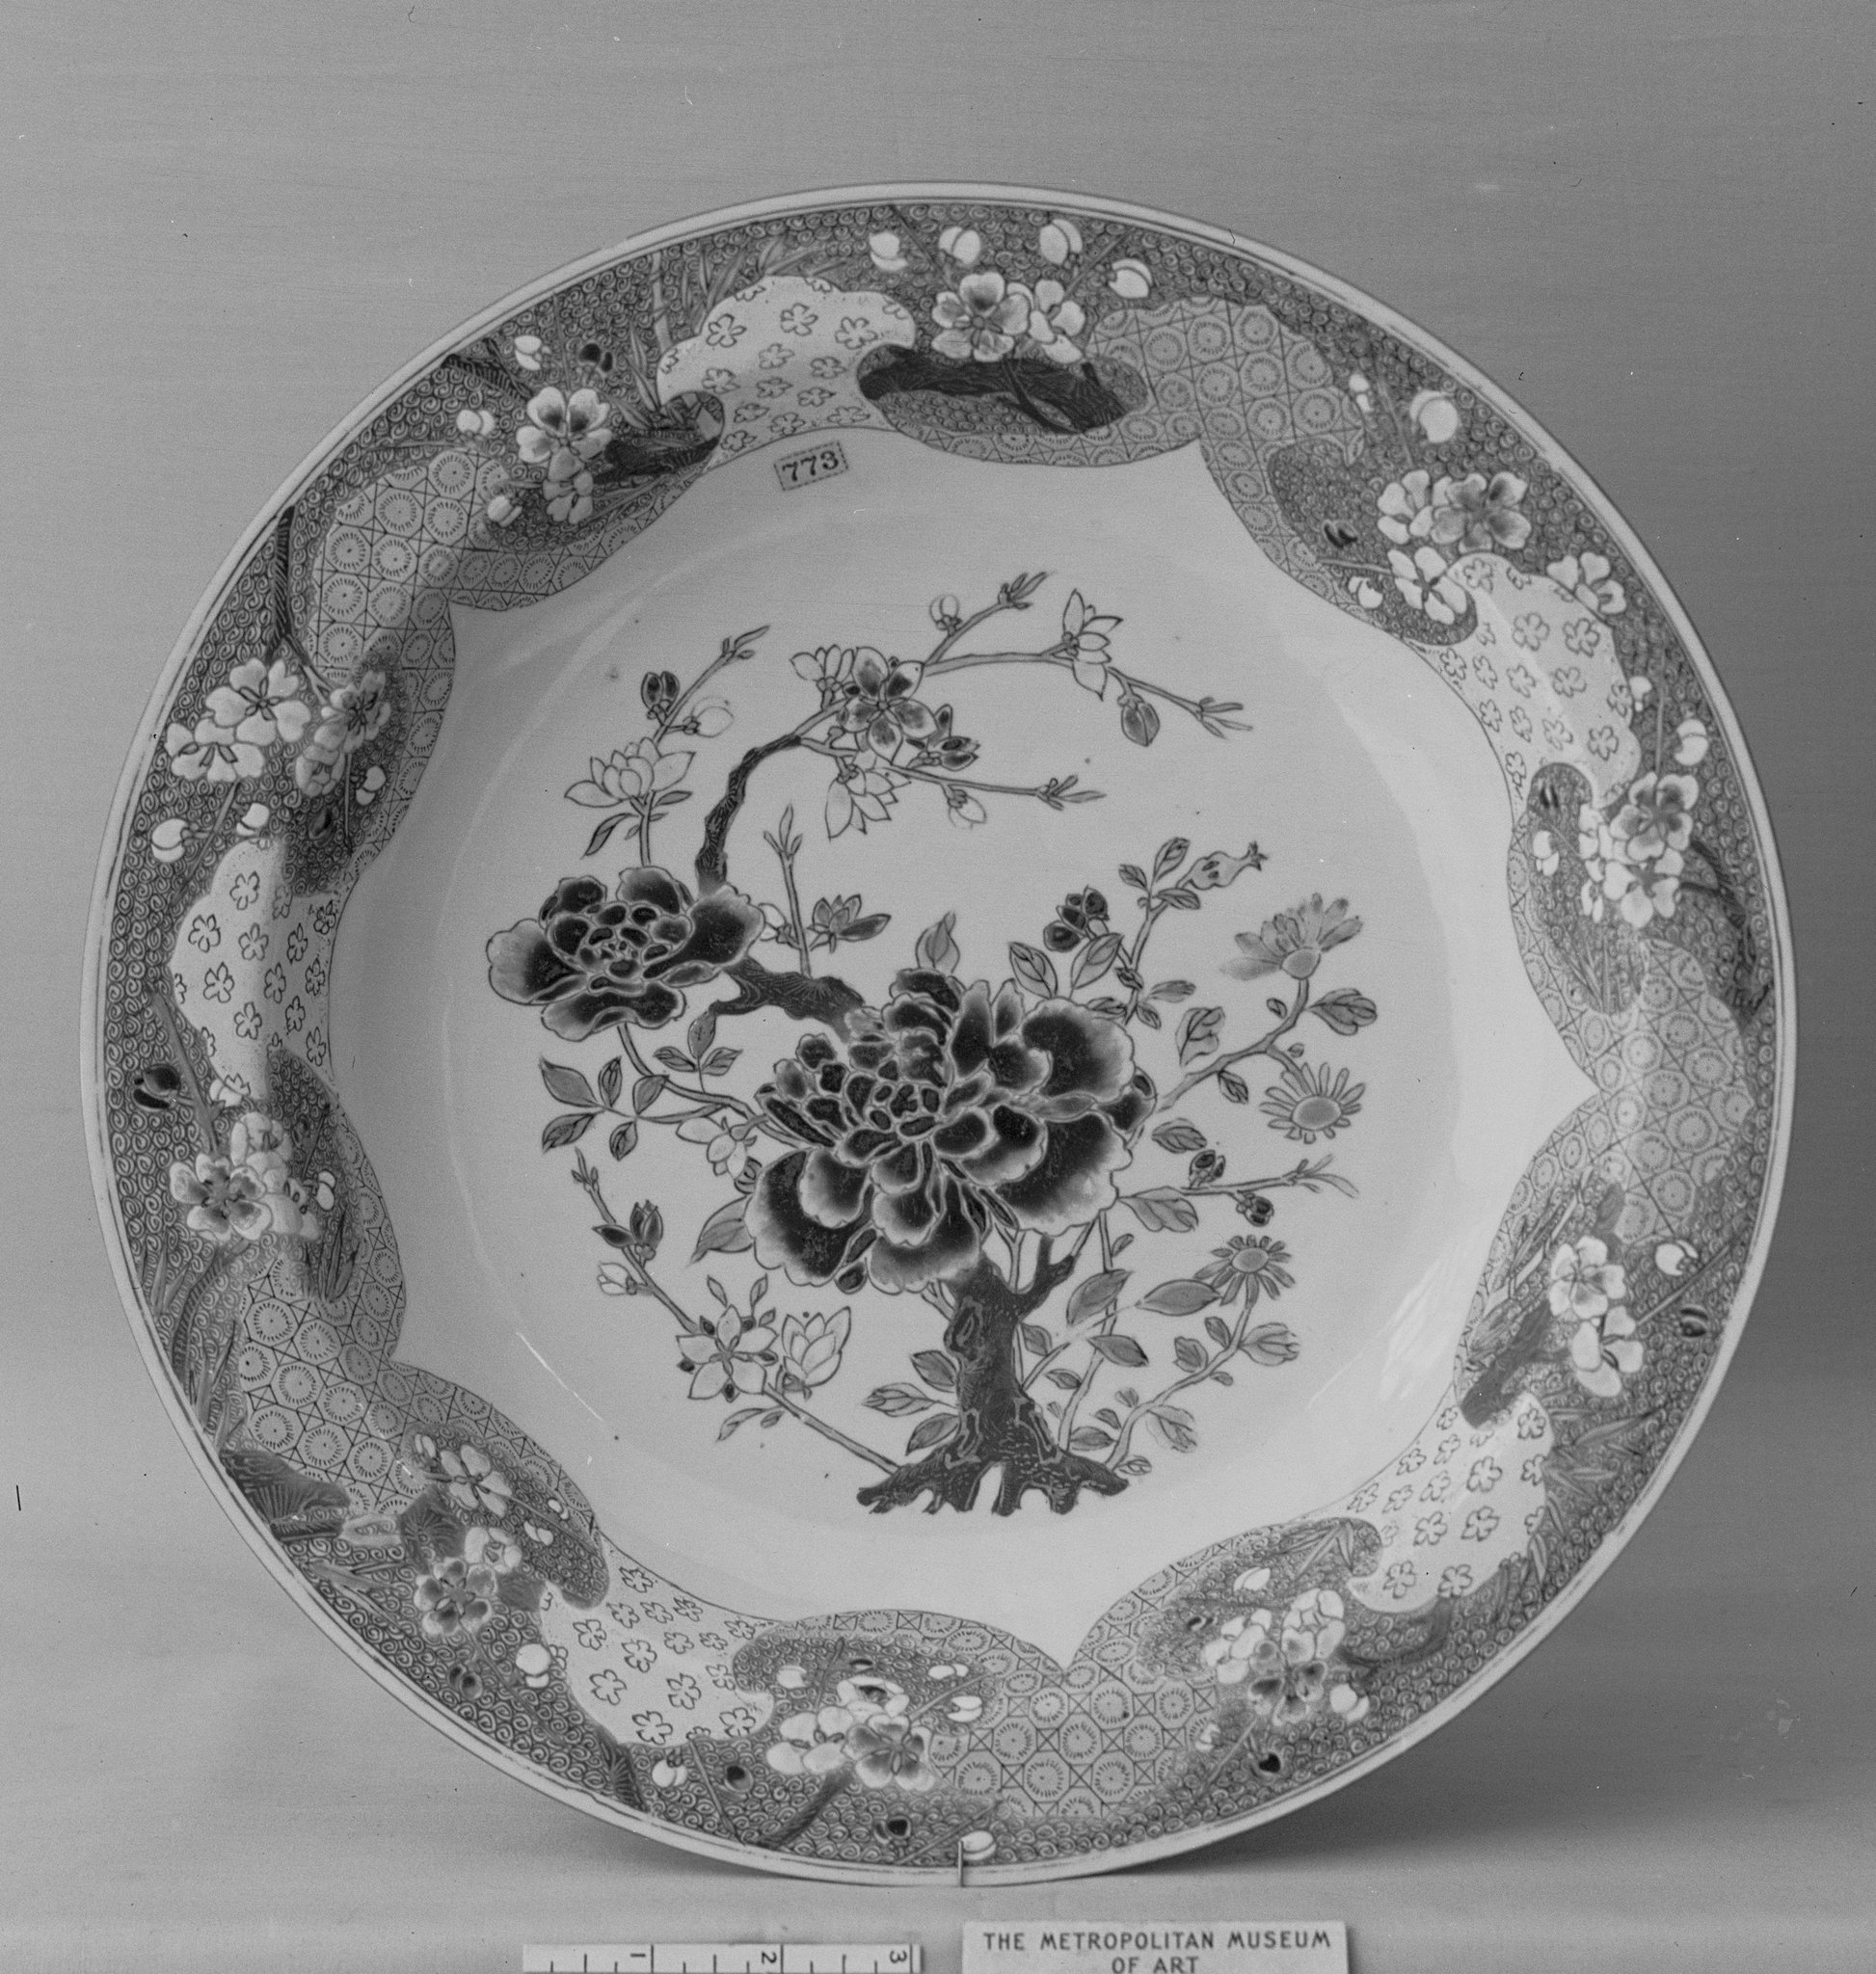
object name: plate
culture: chinese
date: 1736-1795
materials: enamel, porcelain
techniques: overglaze, painting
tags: flowers,plants